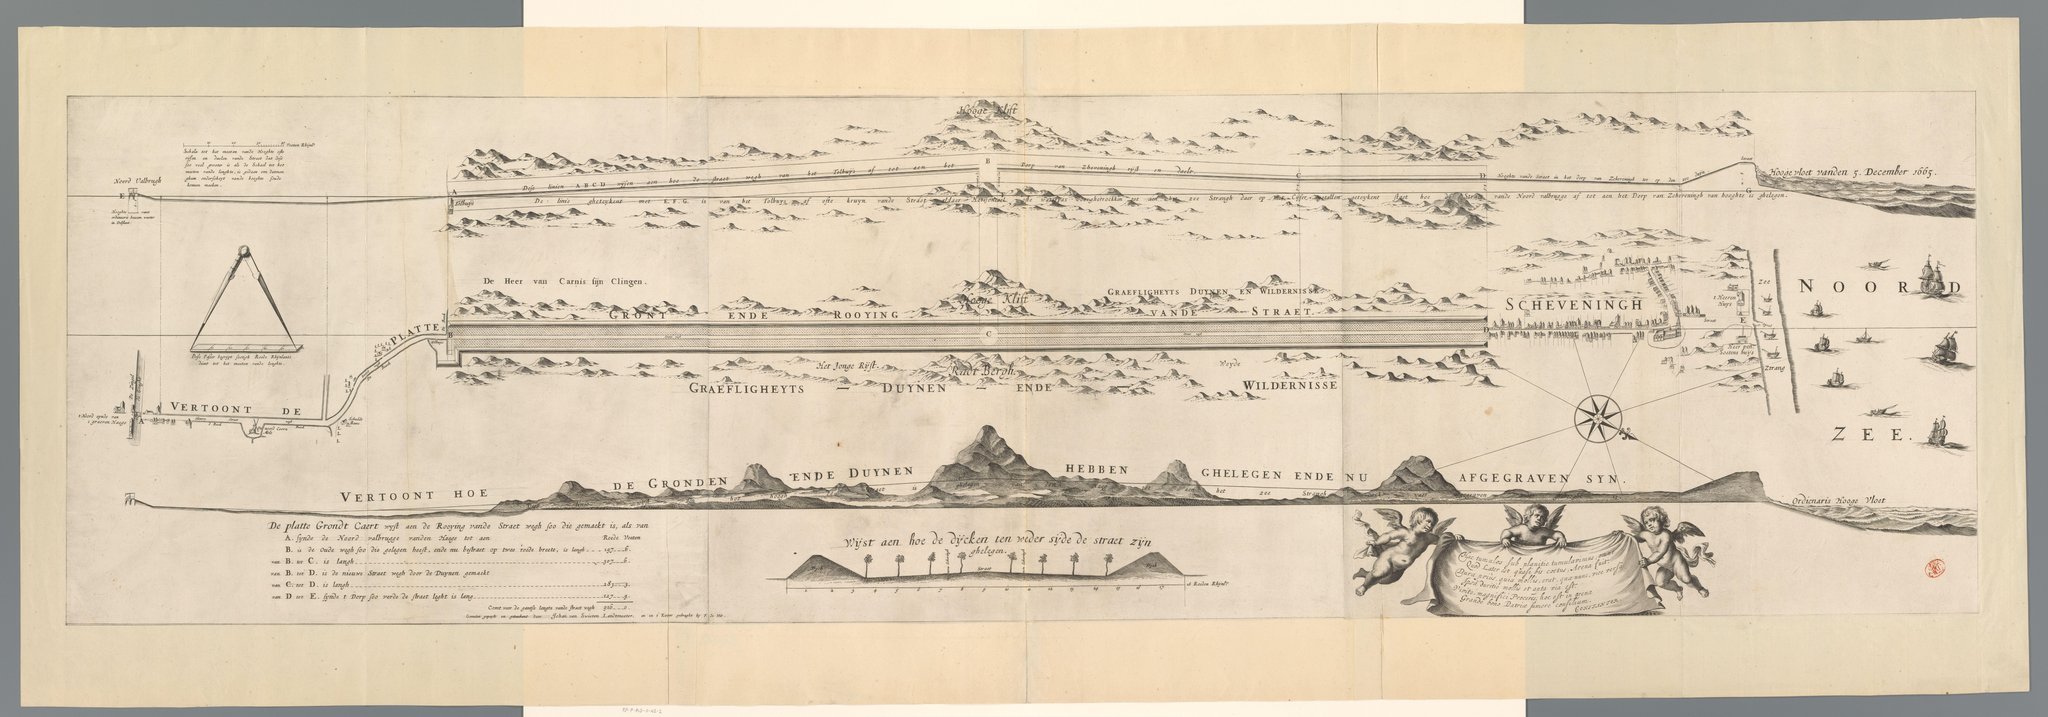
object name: map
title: Caerte van de straet wegh soo die gemaeckt is van Den Hage tot aen 't zee strang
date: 1667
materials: paper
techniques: engraving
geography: amsterdam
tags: maps of separate countries or regions, road, path, the hague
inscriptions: collector's mark: Lugt 2228, collector's mark: Lugt 195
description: Kaart van de aanleg van de straatweg van Den Haag door de duinen naar het strand bij Scheveningen, 1664-1665. Deze weg, vandaag de dag bekend als de Scheveningseweg, werd ontworpen door Constantijn Huygens en in 1665 voltooid. Linksboven een schaalstok voor het meten van de hoogte: 40 voeten Rhijnlt. Daaronder een passer met een schaalstok voor het meten van de lengte: Dese passer begrijpt sestigh roede Rhijnlants. Onder in het midden een dwarsdoorsnede van de straatweg met een schaalstok: 18 roeden Rijnlts. Rechts daarvan een doek opgehouden door drie putti met een Latijns vers door Huygens. Rechtsboven staat de hoogte van de waterstand bij de stormvloed van 5 december 1665 aangegeven.